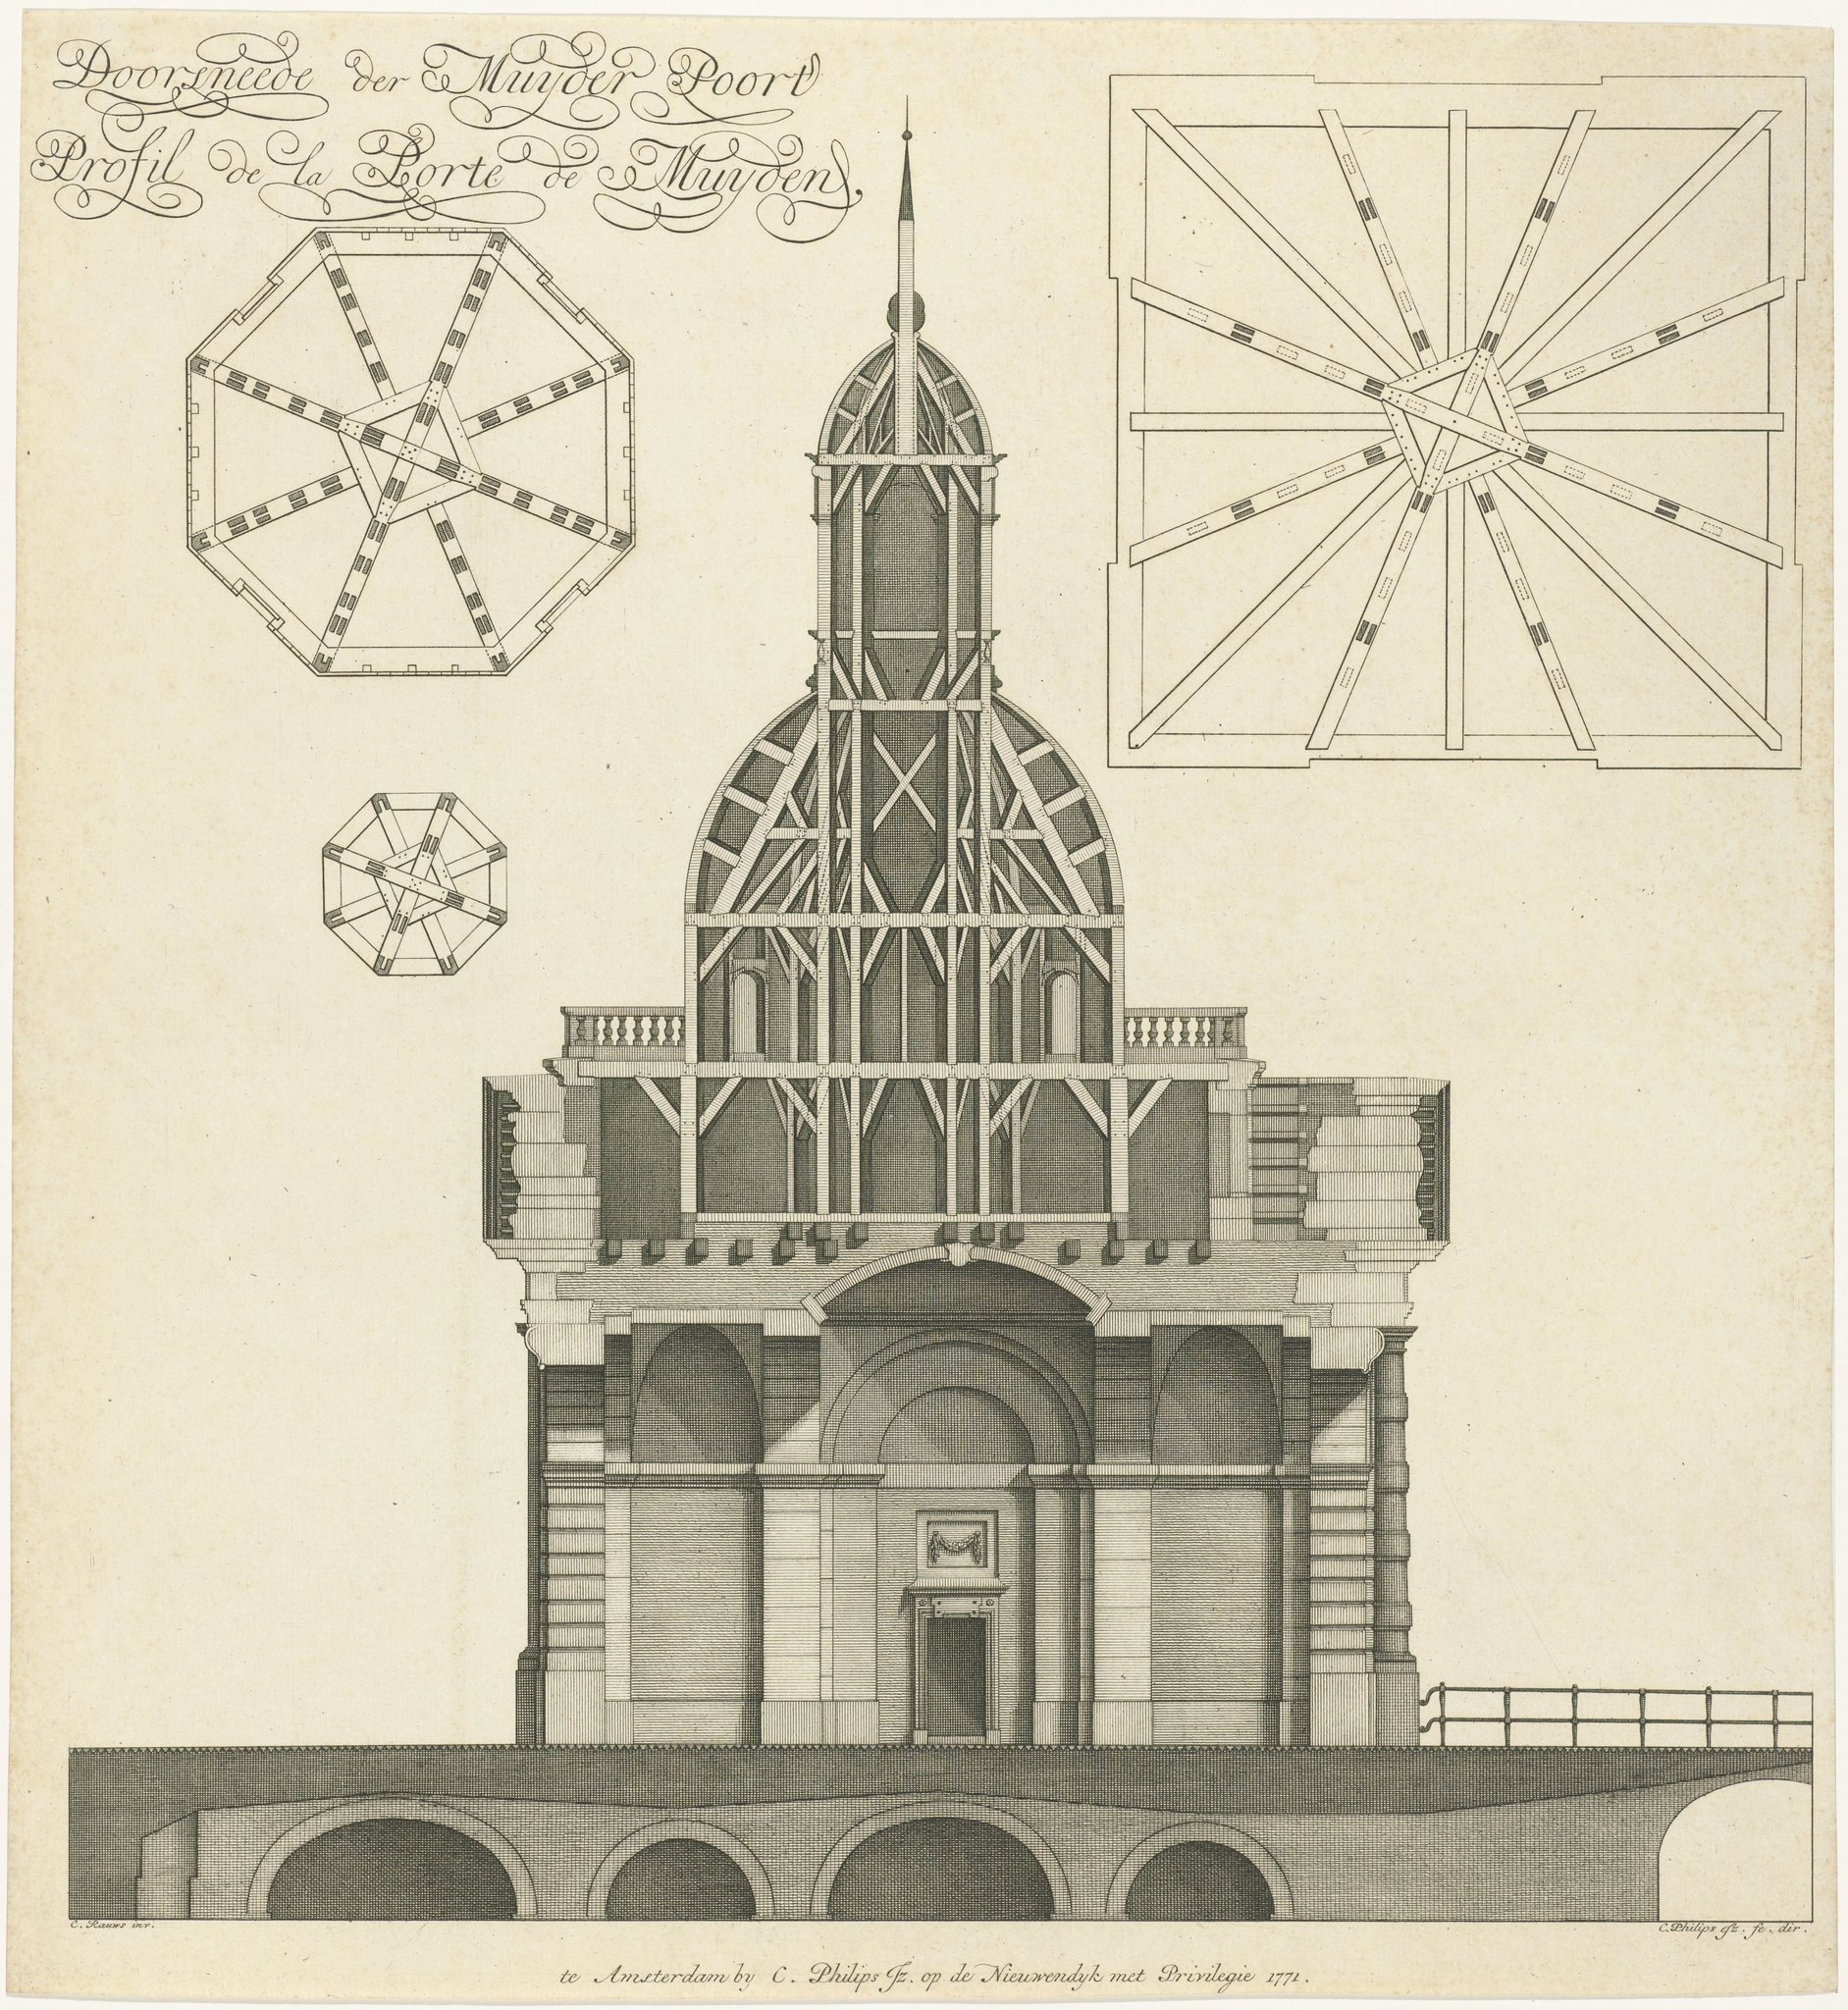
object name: print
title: Doorsneede der Muyder Poort / Profil de la Porte de Muyden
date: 1771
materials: paper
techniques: engraving, etching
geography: amsterdam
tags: series of designs, models, etc. of one architectural project, city-gate, section ~ architectural design or model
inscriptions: collector's mark: Lugt 2228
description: Doorsnede van de Tweede Muiderpoort te Amsterdam, met links de kant die binnen de stad lag en rechts de kant met de toegangsbrug buiten te stad. Linksboven de titel in het Nederlands en Frans. Links en rechts van de koepel details voor de constructie daarvan. Rechtsboven genummerd: V. Onderdeel van een serie van zes prenten van de Tweede Muiderpoort, gemaakt naar de ontwerptekeningen van stadsbouwmeester Cornelis Rauws. Deze stadspoort werd in 1770 gebouwd nadat de Eerste Muiderpoort in 1769 verzakte.